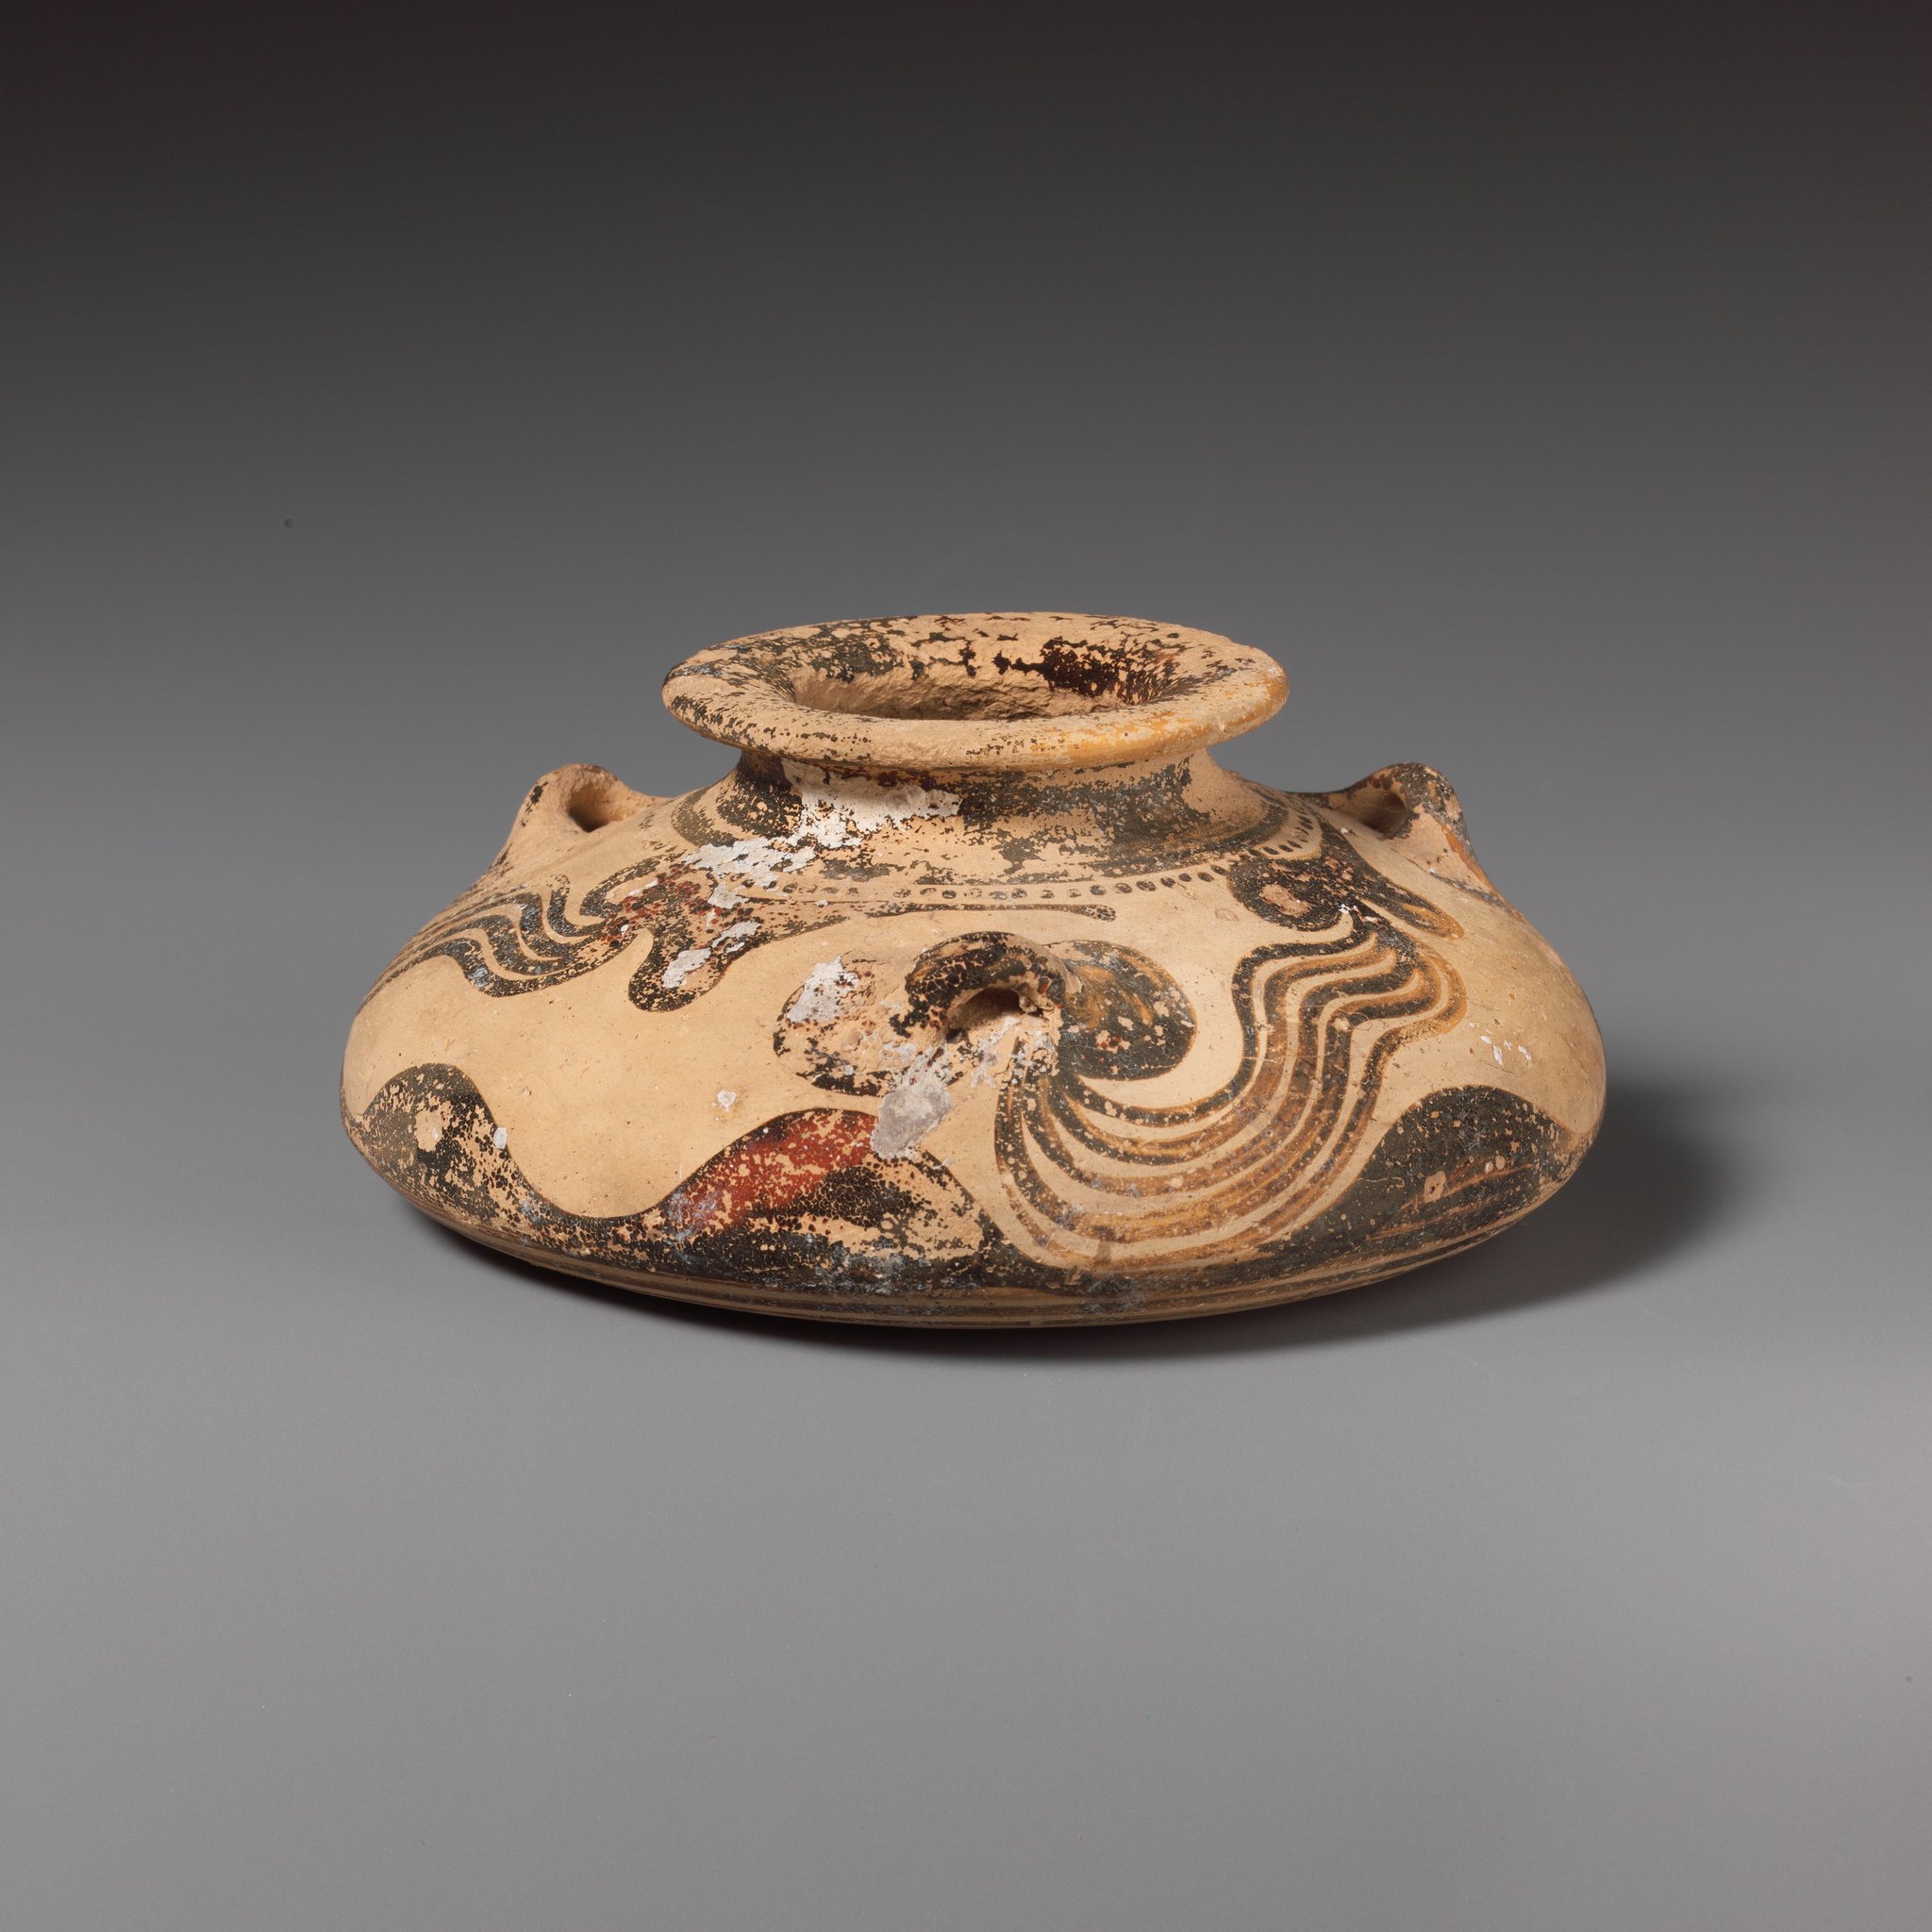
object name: alabastron, squat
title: Terracotta squat alabastron (jar)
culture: mycenaean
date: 1300-1201 BCE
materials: terracotta